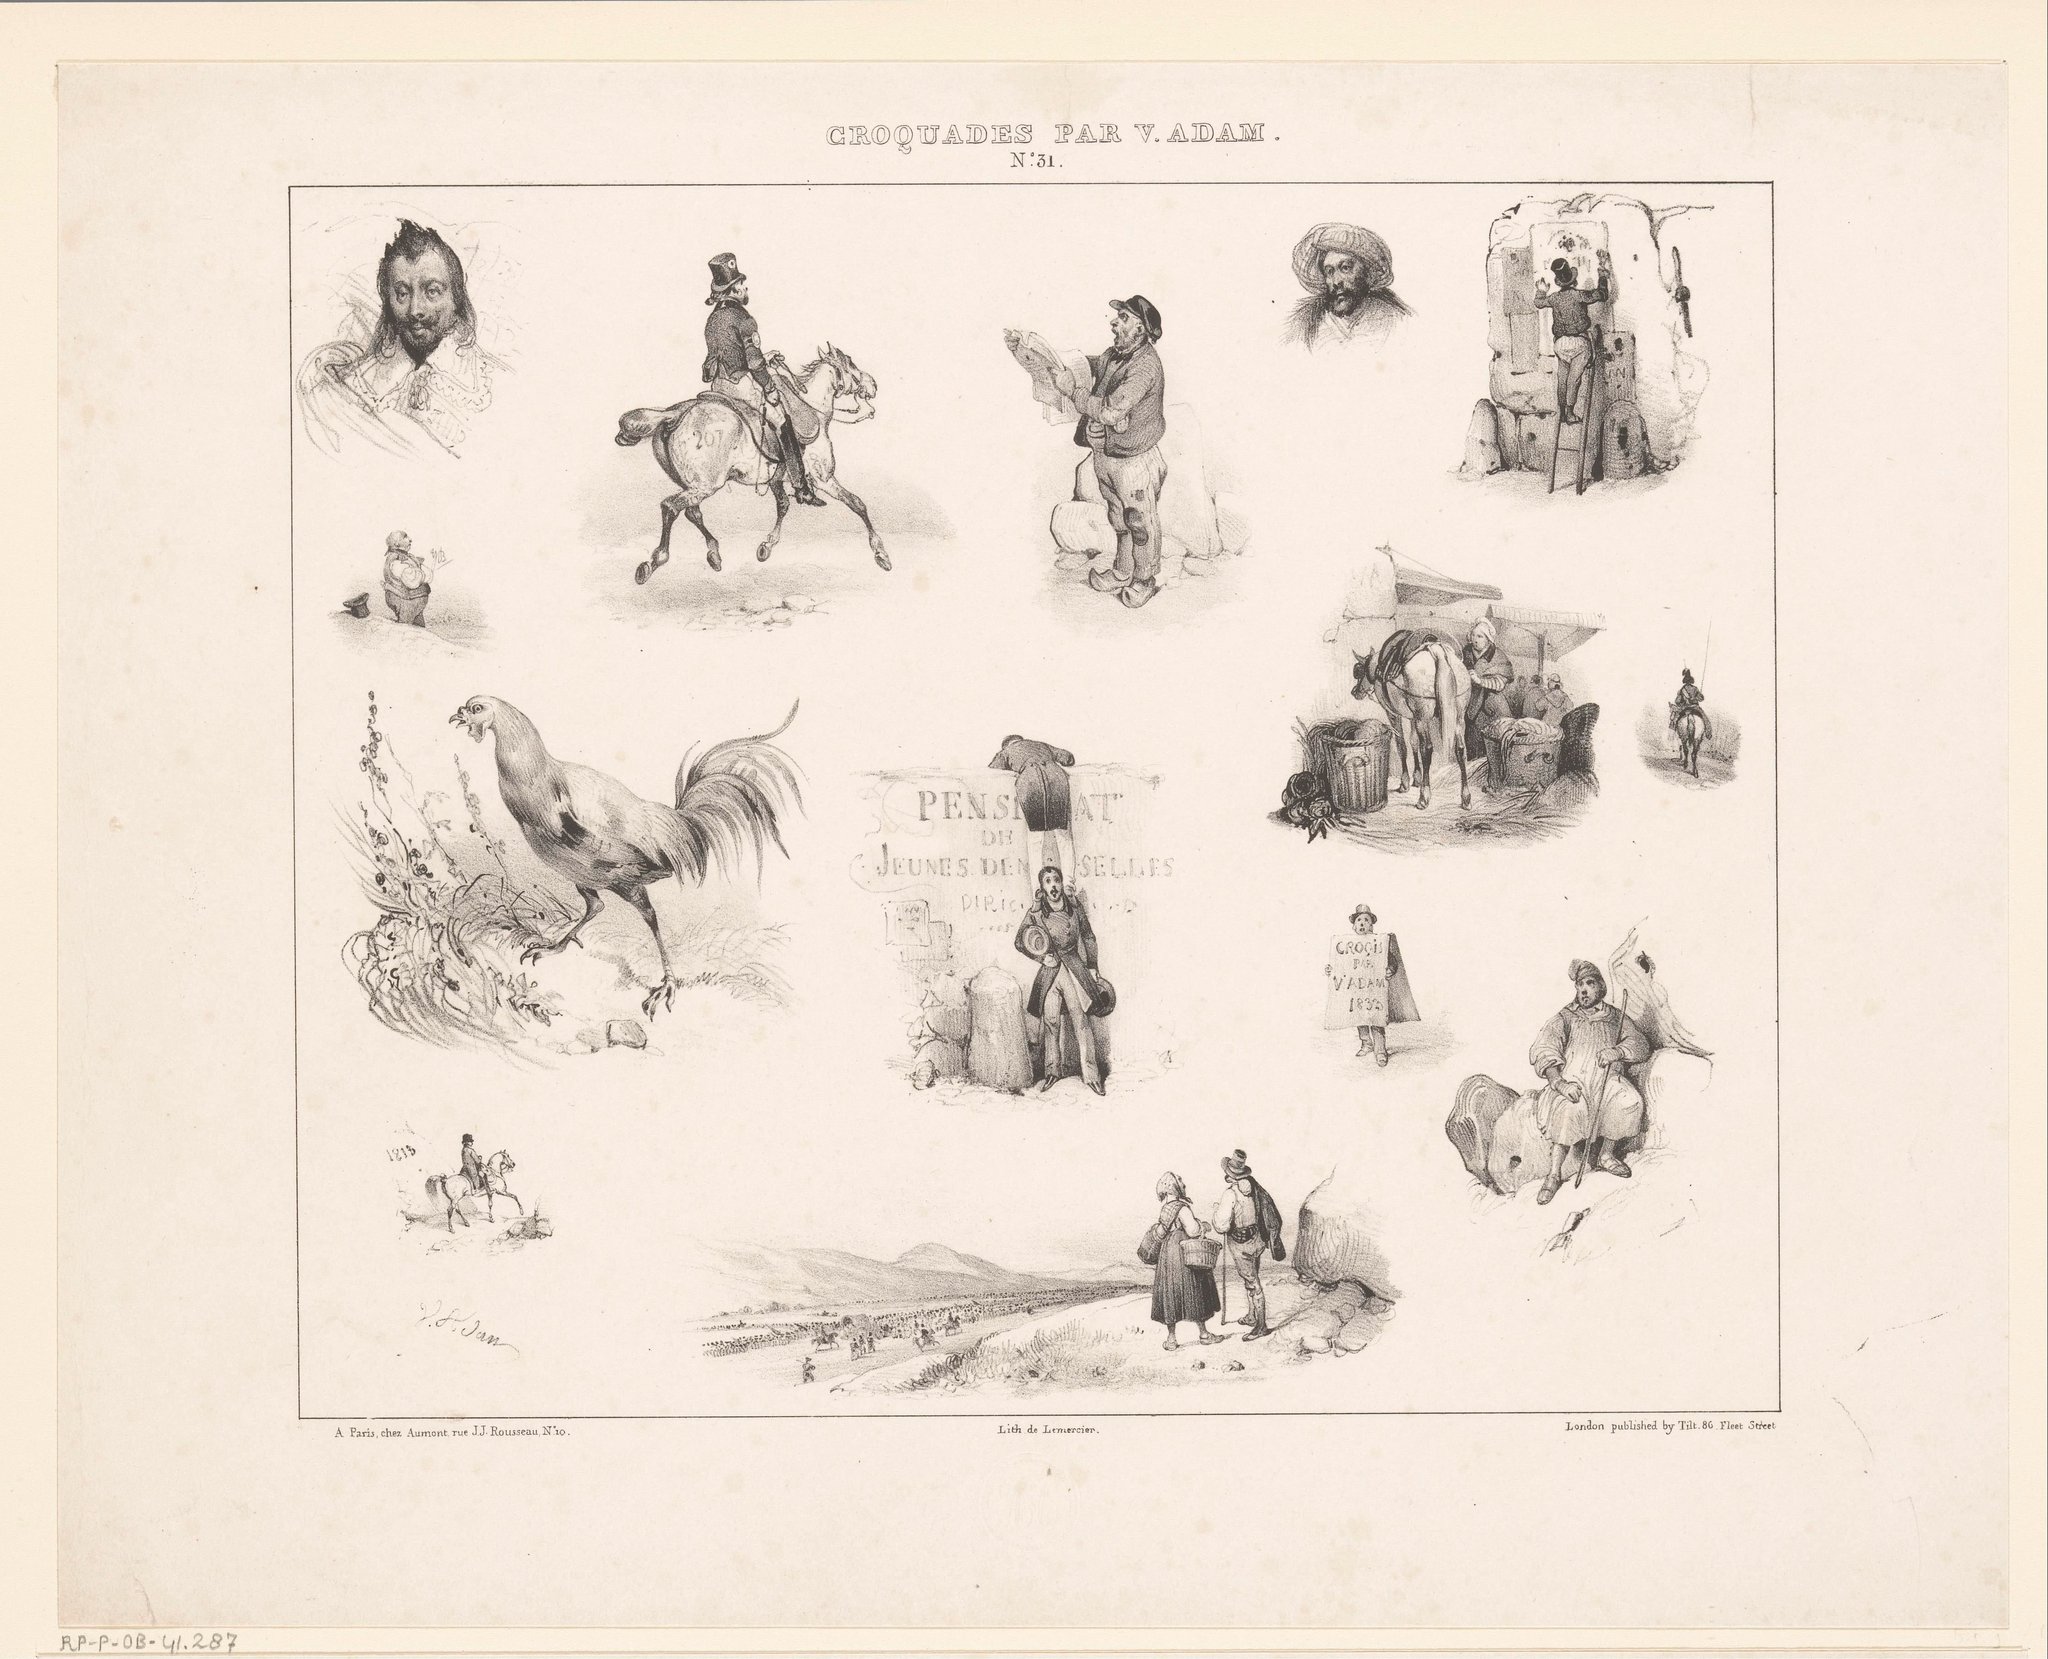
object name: print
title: Schetsen van diverse onderwerpen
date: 1833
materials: paper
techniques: lithograph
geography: paris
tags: riding a horse, ass, or mule; rider, horseman, advertising, farmers, fowl (cock, hen, chicken, etc.), horse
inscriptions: check stamp: Lugt 88b